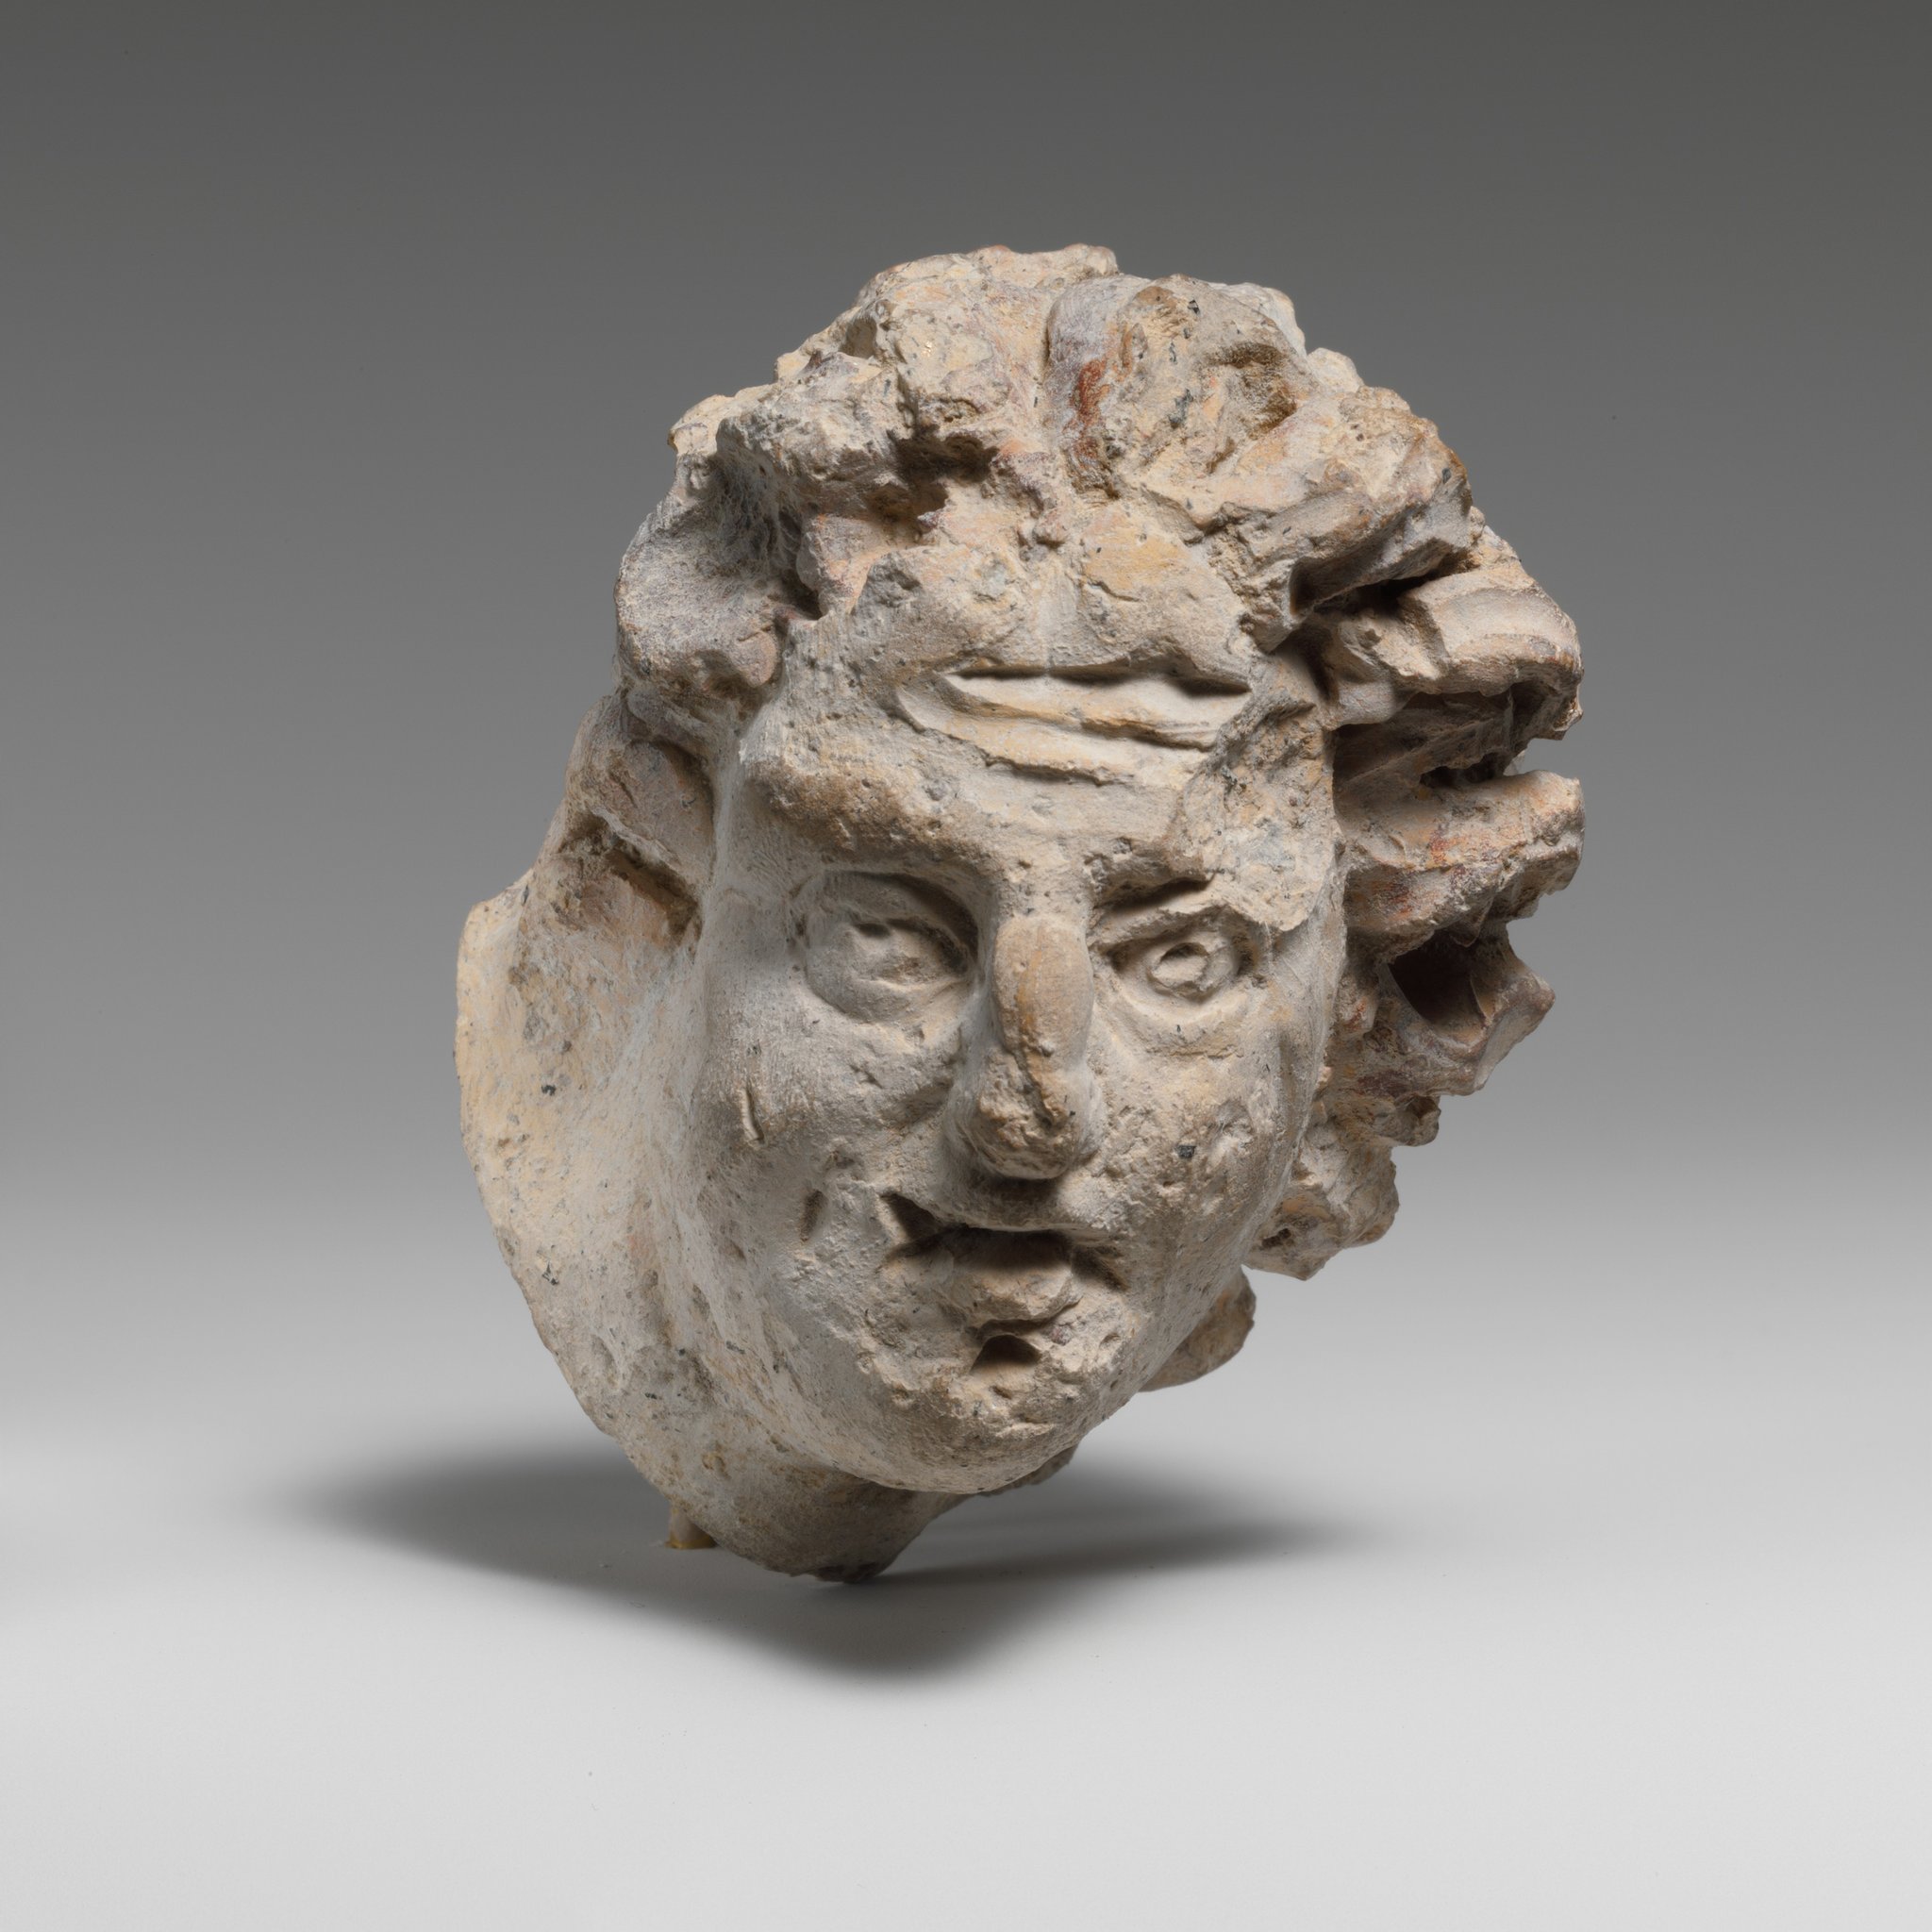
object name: head of a man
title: Terracotta head of a man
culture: greek, south italian, tarentine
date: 300-101 BCE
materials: terracotta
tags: heads,men